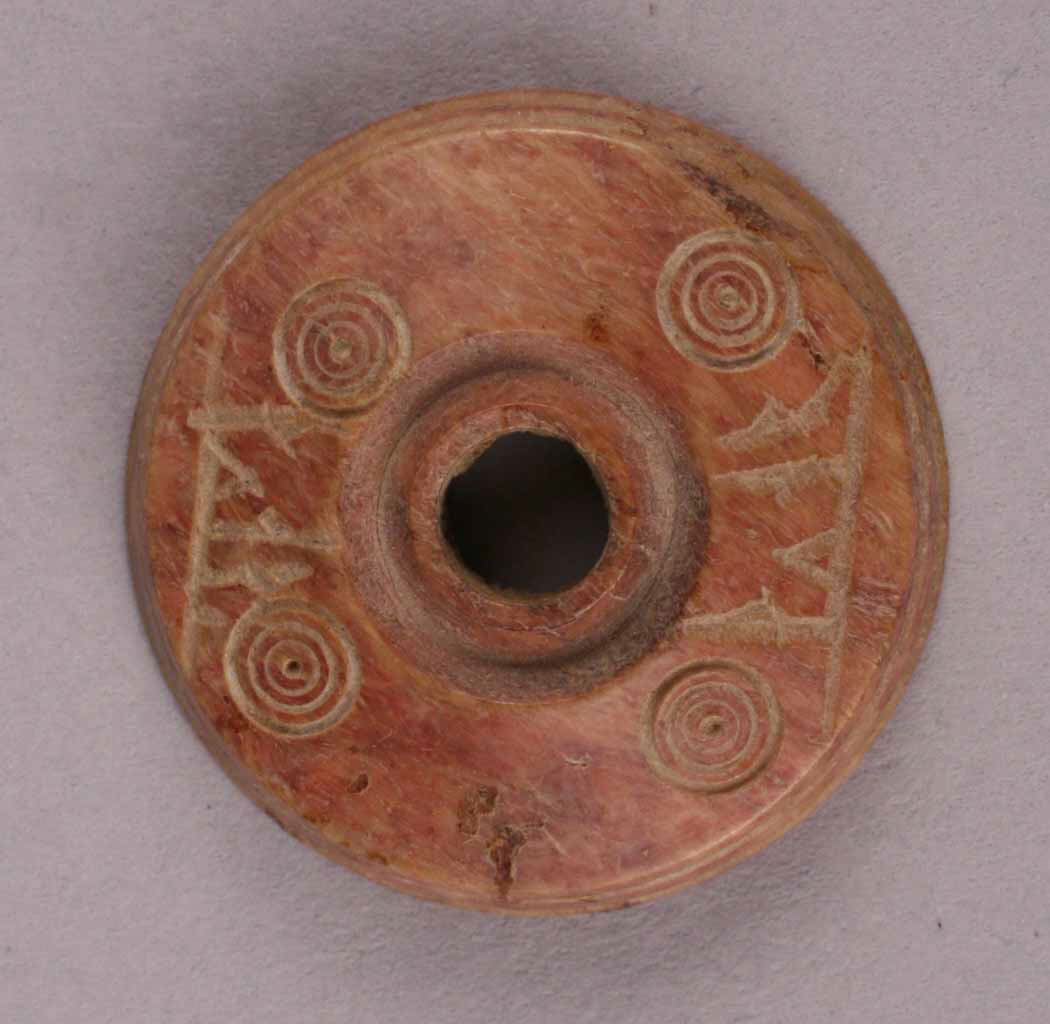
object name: button or bead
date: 801-1000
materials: bone, paint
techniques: incising, inlay, tinting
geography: iran